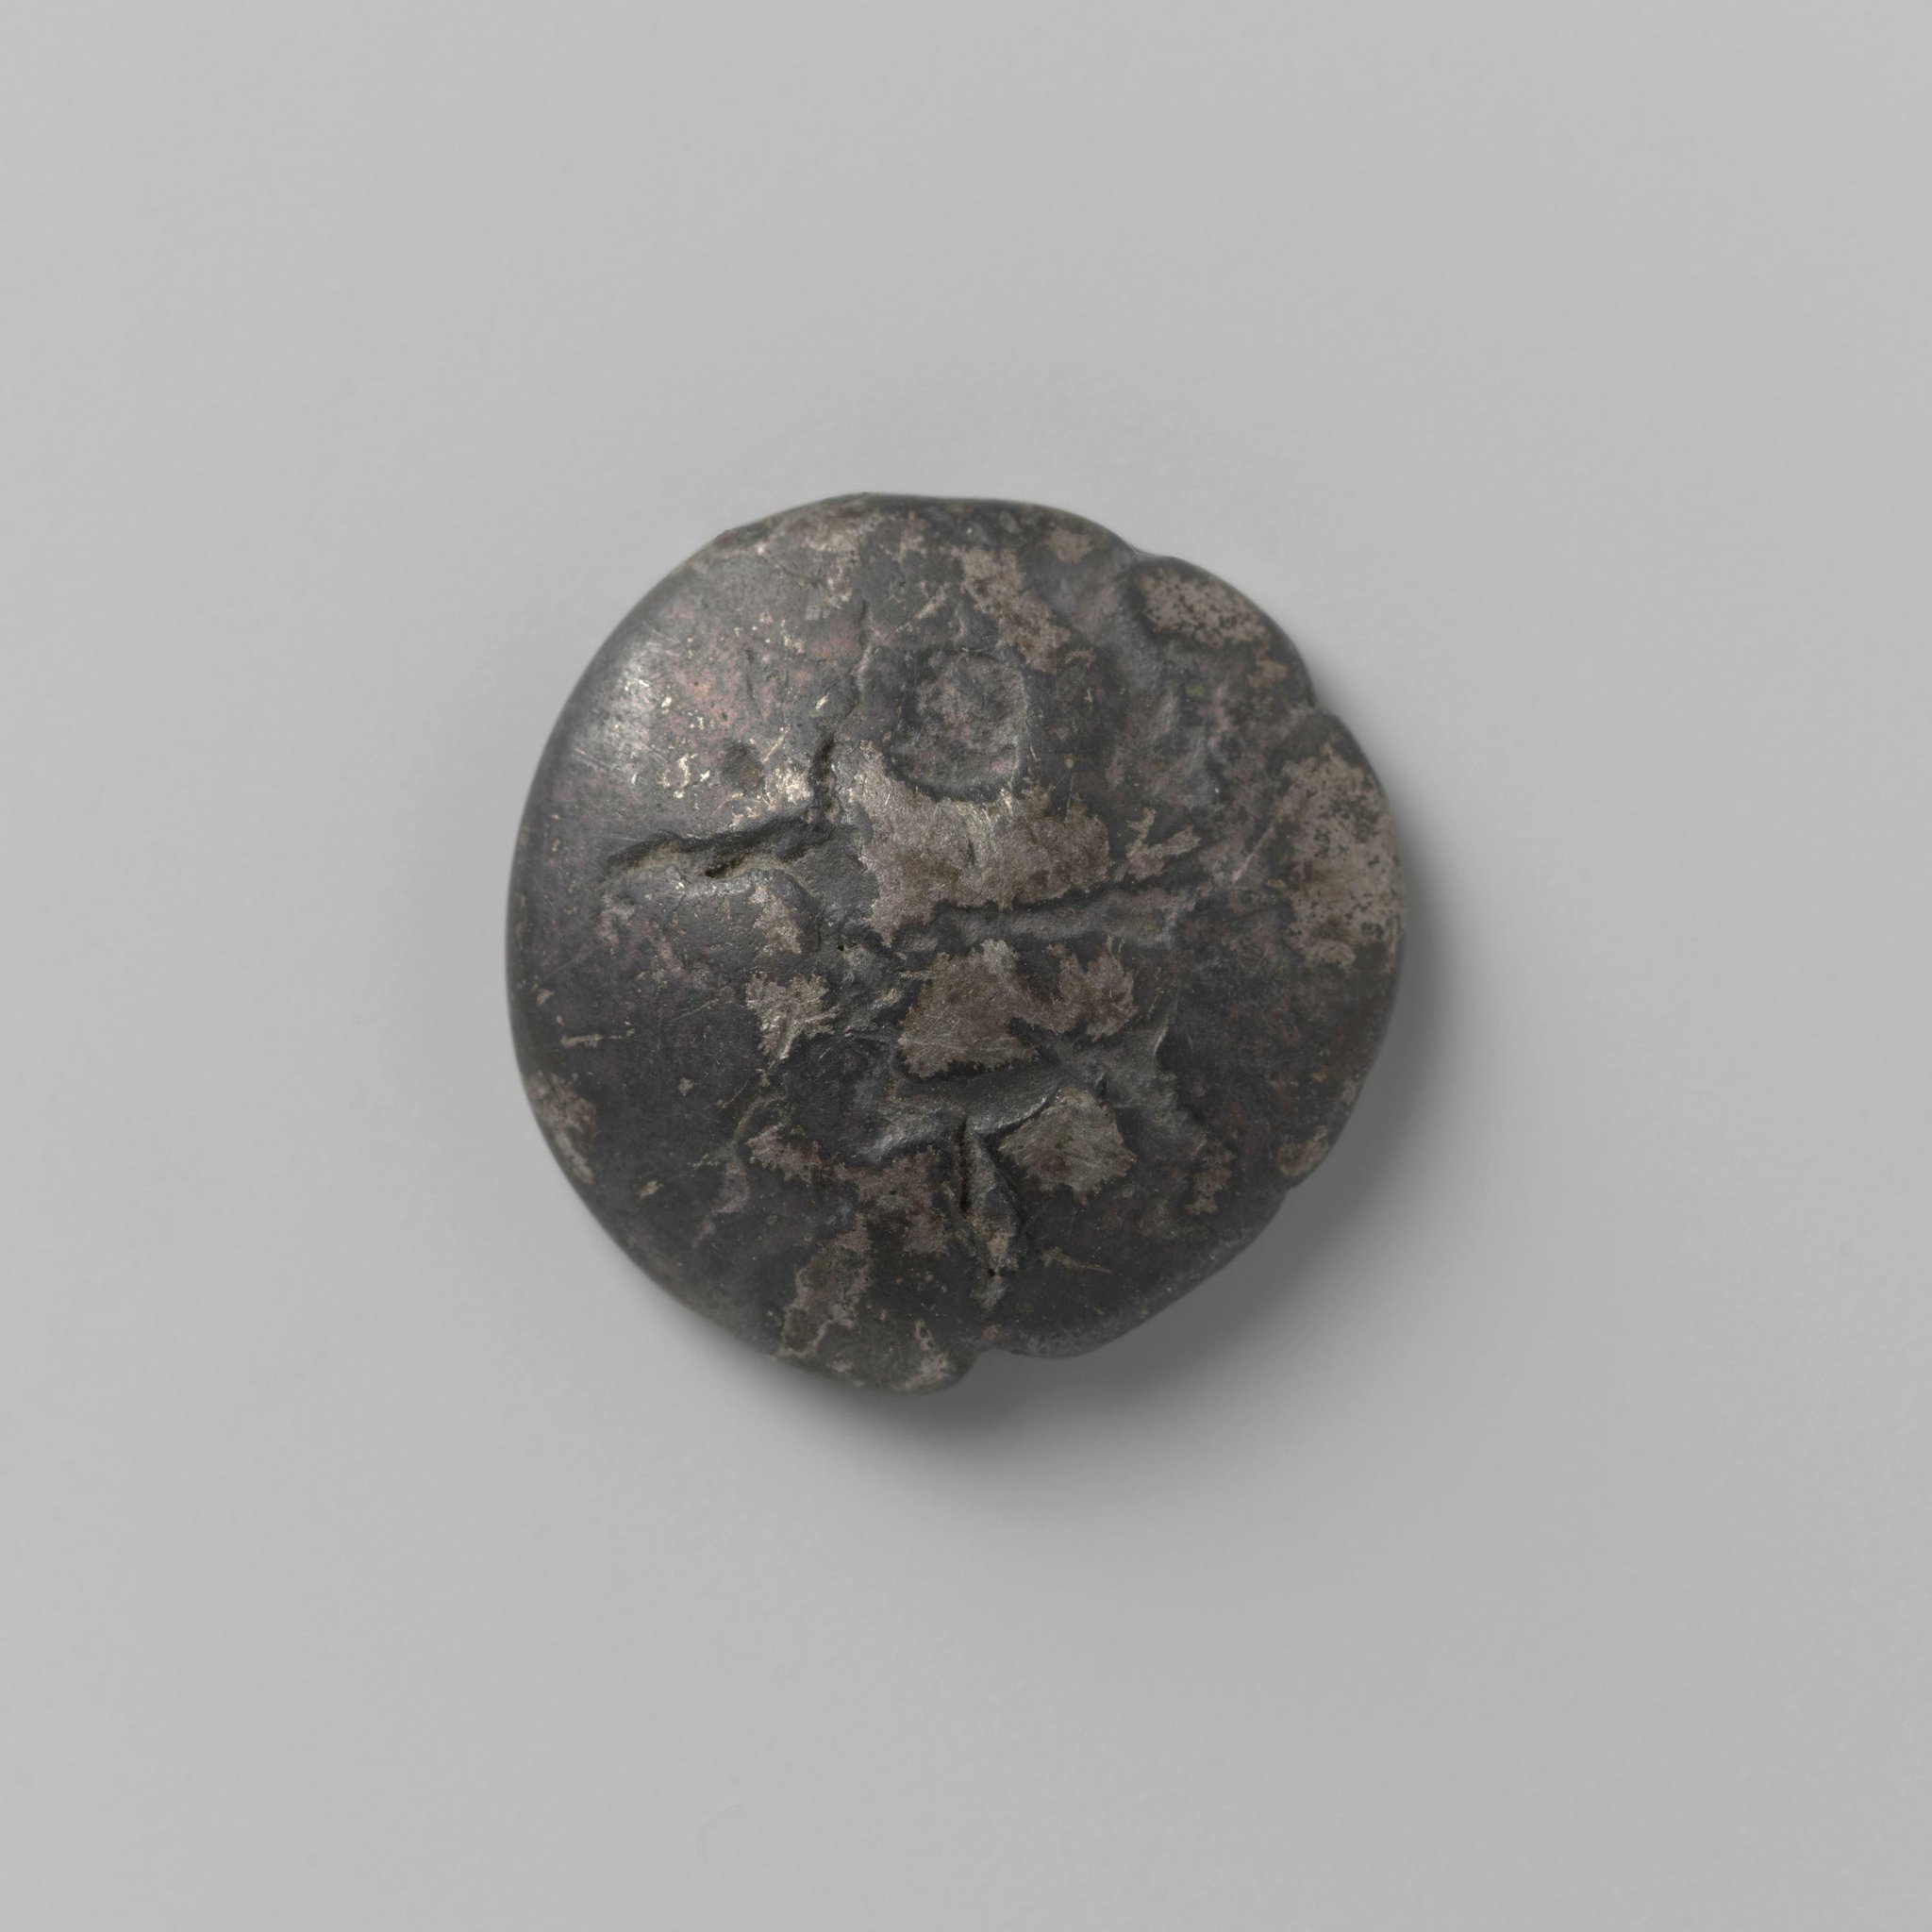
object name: coin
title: Java, koninkrijk Majopahit, djampel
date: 1290-1520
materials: silver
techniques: striking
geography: java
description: Zilveren schotelvormige munt. Voorzijde: letterteken in devanagari-schrift [maa?]. Keerzijde, figuratie [bloem?].